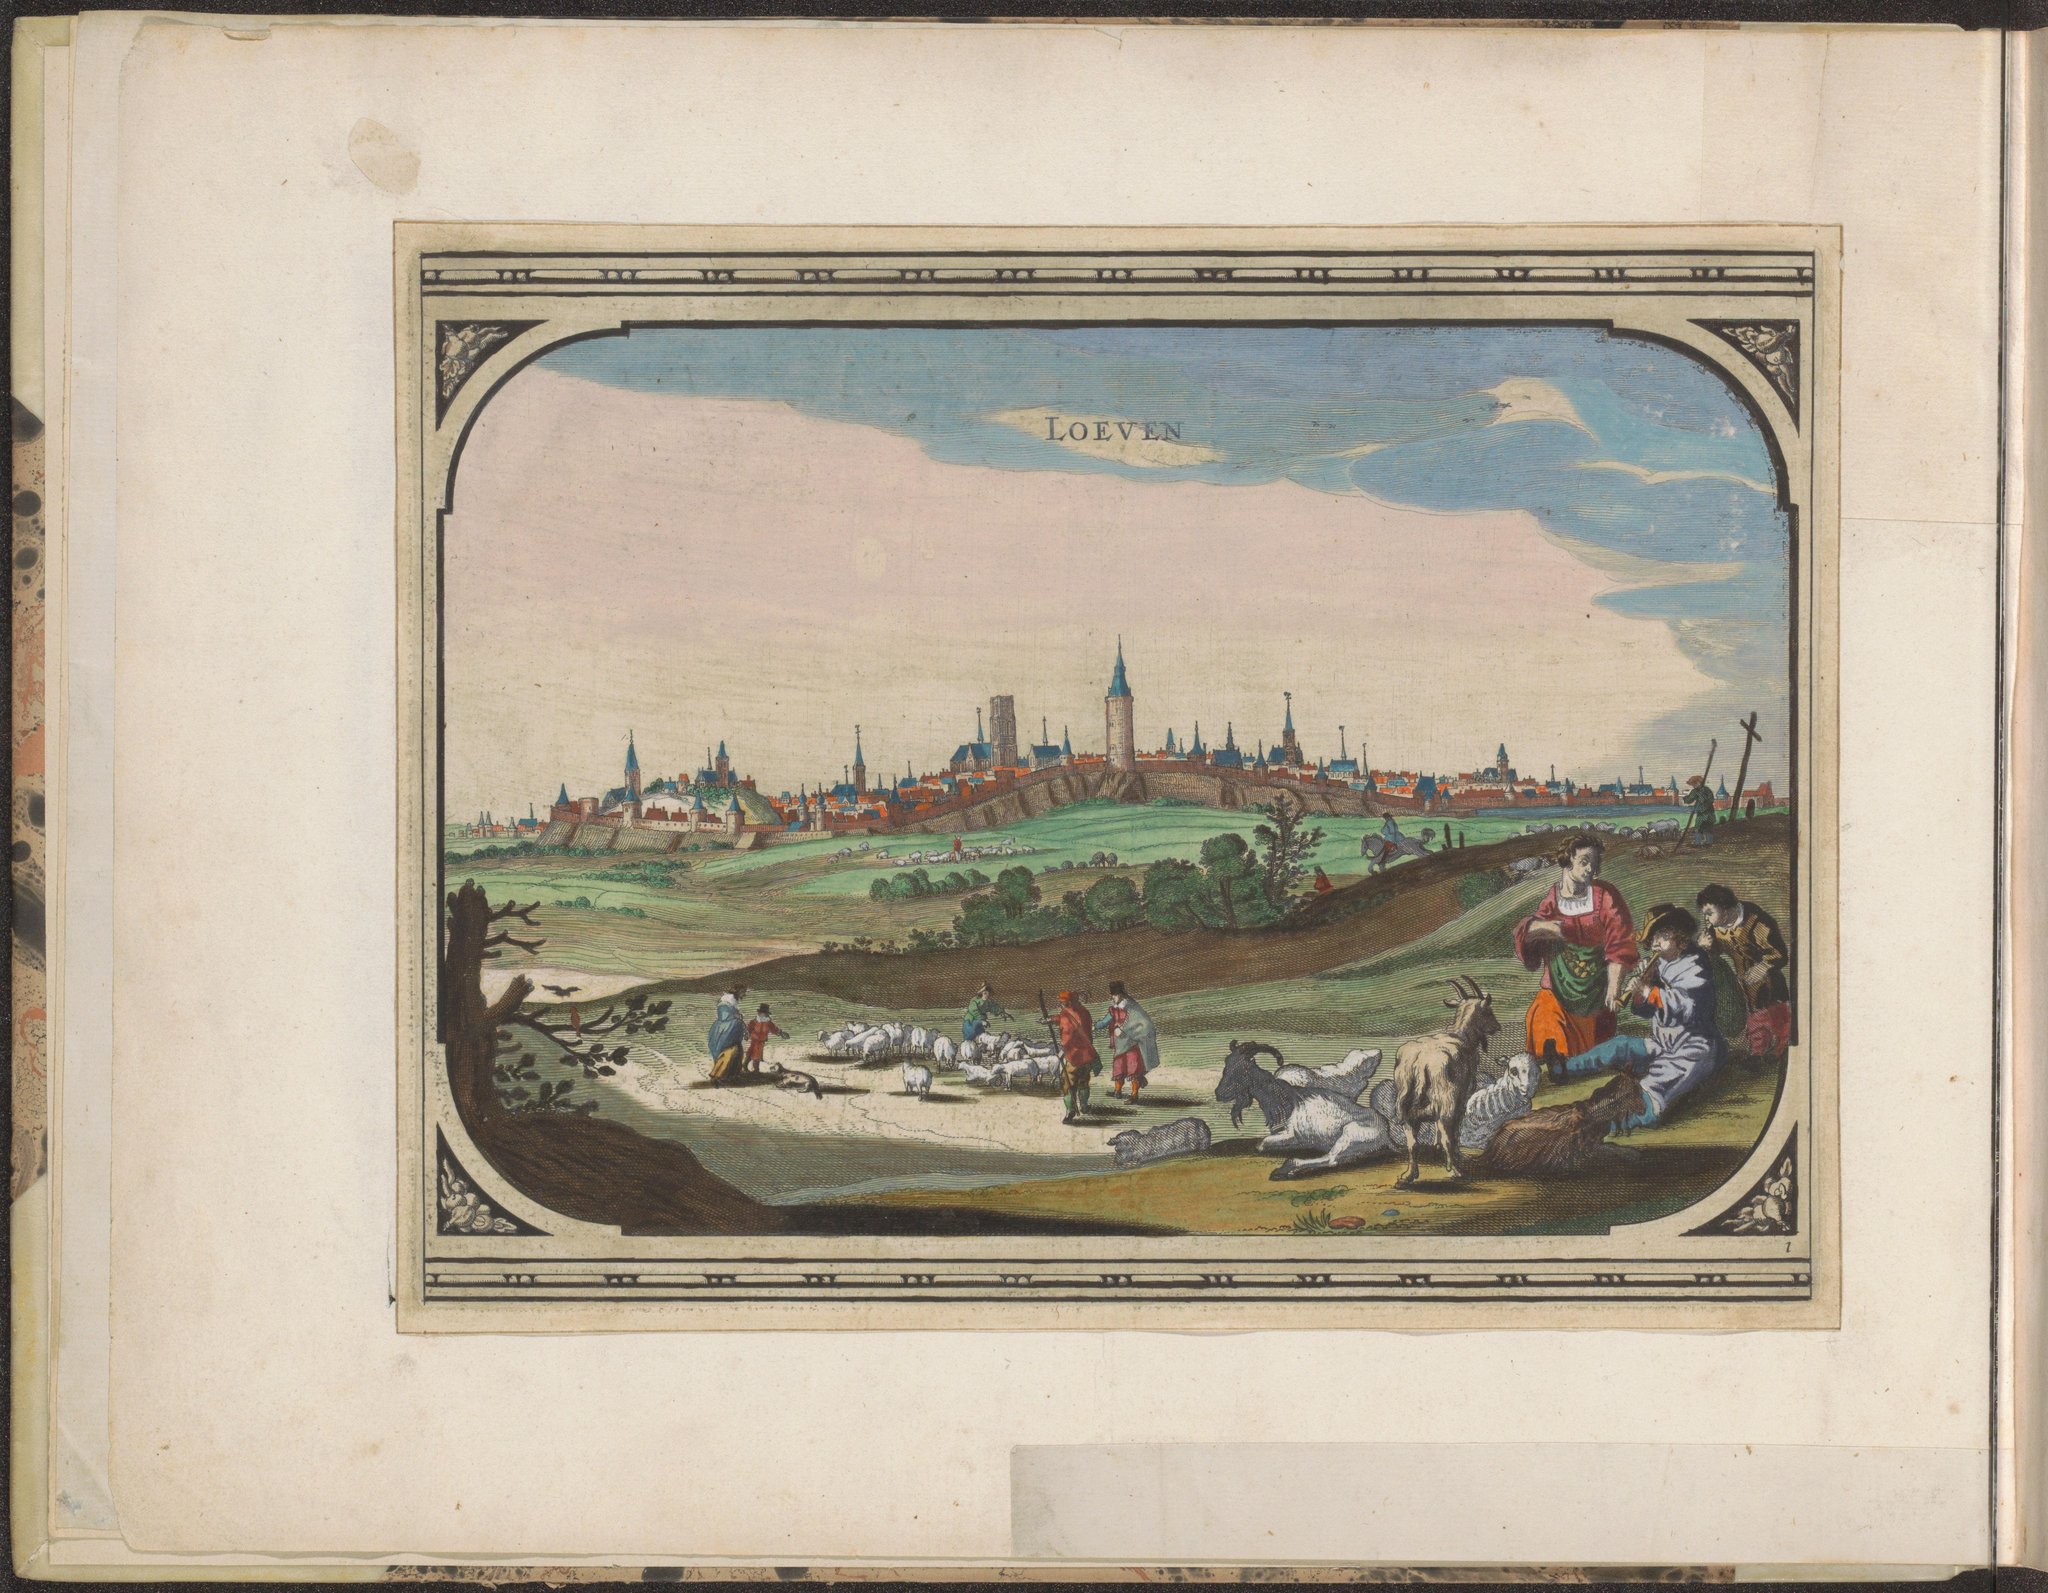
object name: album leaf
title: Loeven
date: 1657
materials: paper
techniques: etching, hand coloring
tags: city-view, and landscape with man-made constructions, herding, herdsman, herdswoman, shepherd, shepherdess, cowherd, etc., louvain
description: Gezicht op de stad Leuven. Op de voorgrond enkele herders. Rechts speelt een man op een fluit. Naast hem heeft een vrouw appels of pruimen in de schort van haar jurk. Een jongen neemt een hap van één van de vruchten. De prent maakt deel uit van een album.